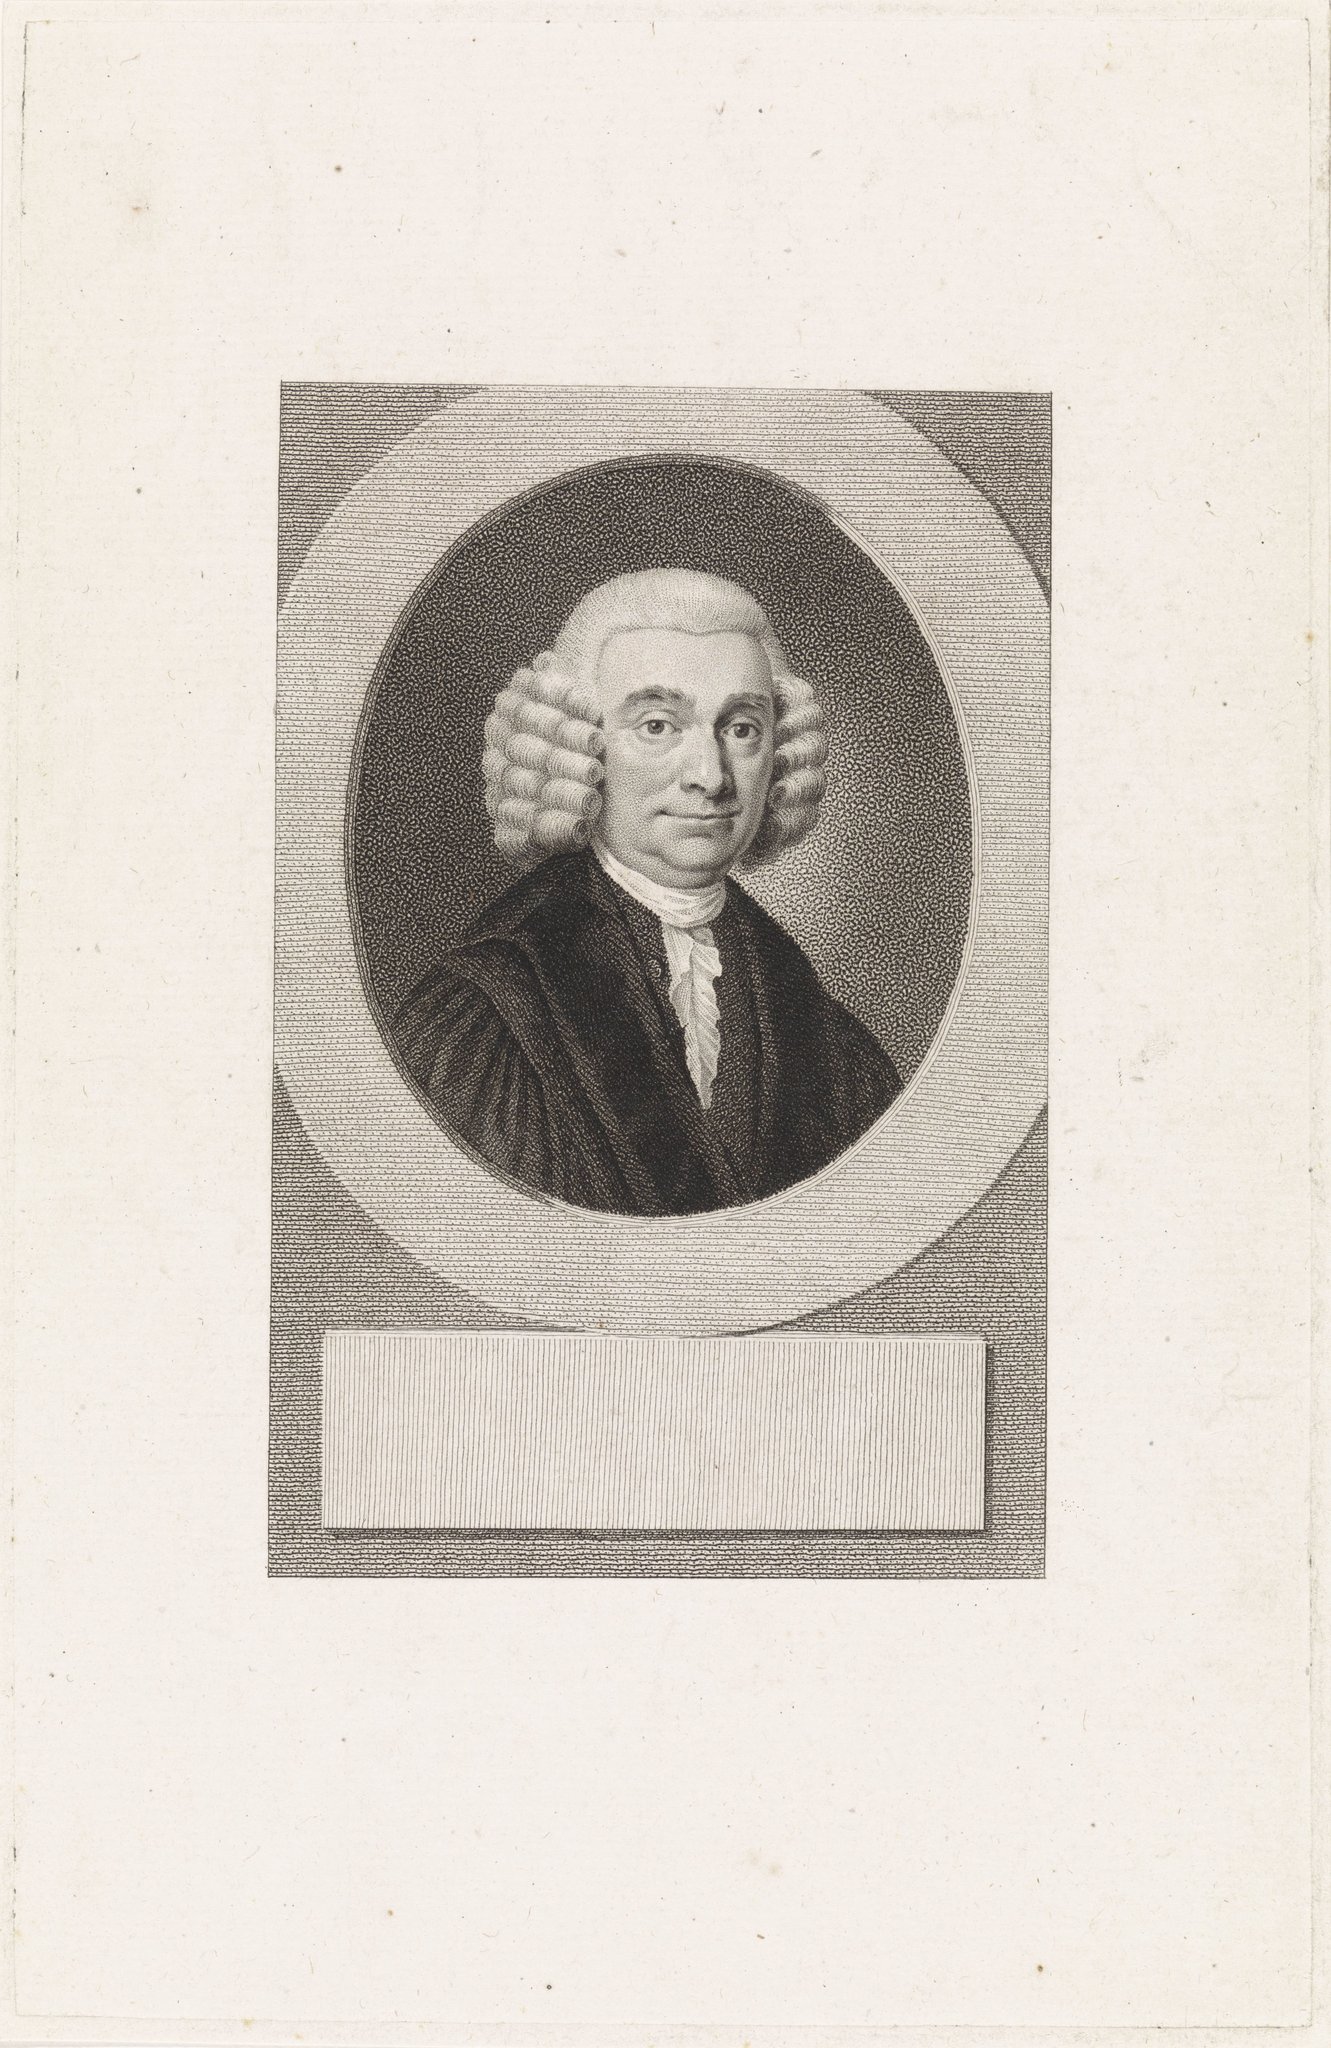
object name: print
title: Portret van professor Adriaan Kluit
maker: ludwig gottlieb portman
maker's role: print maker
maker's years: 1772-1828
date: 1787-1828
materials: paper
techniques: stippled etching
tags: dordrecht, leiden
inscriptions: collector's mark: Lugt 2228